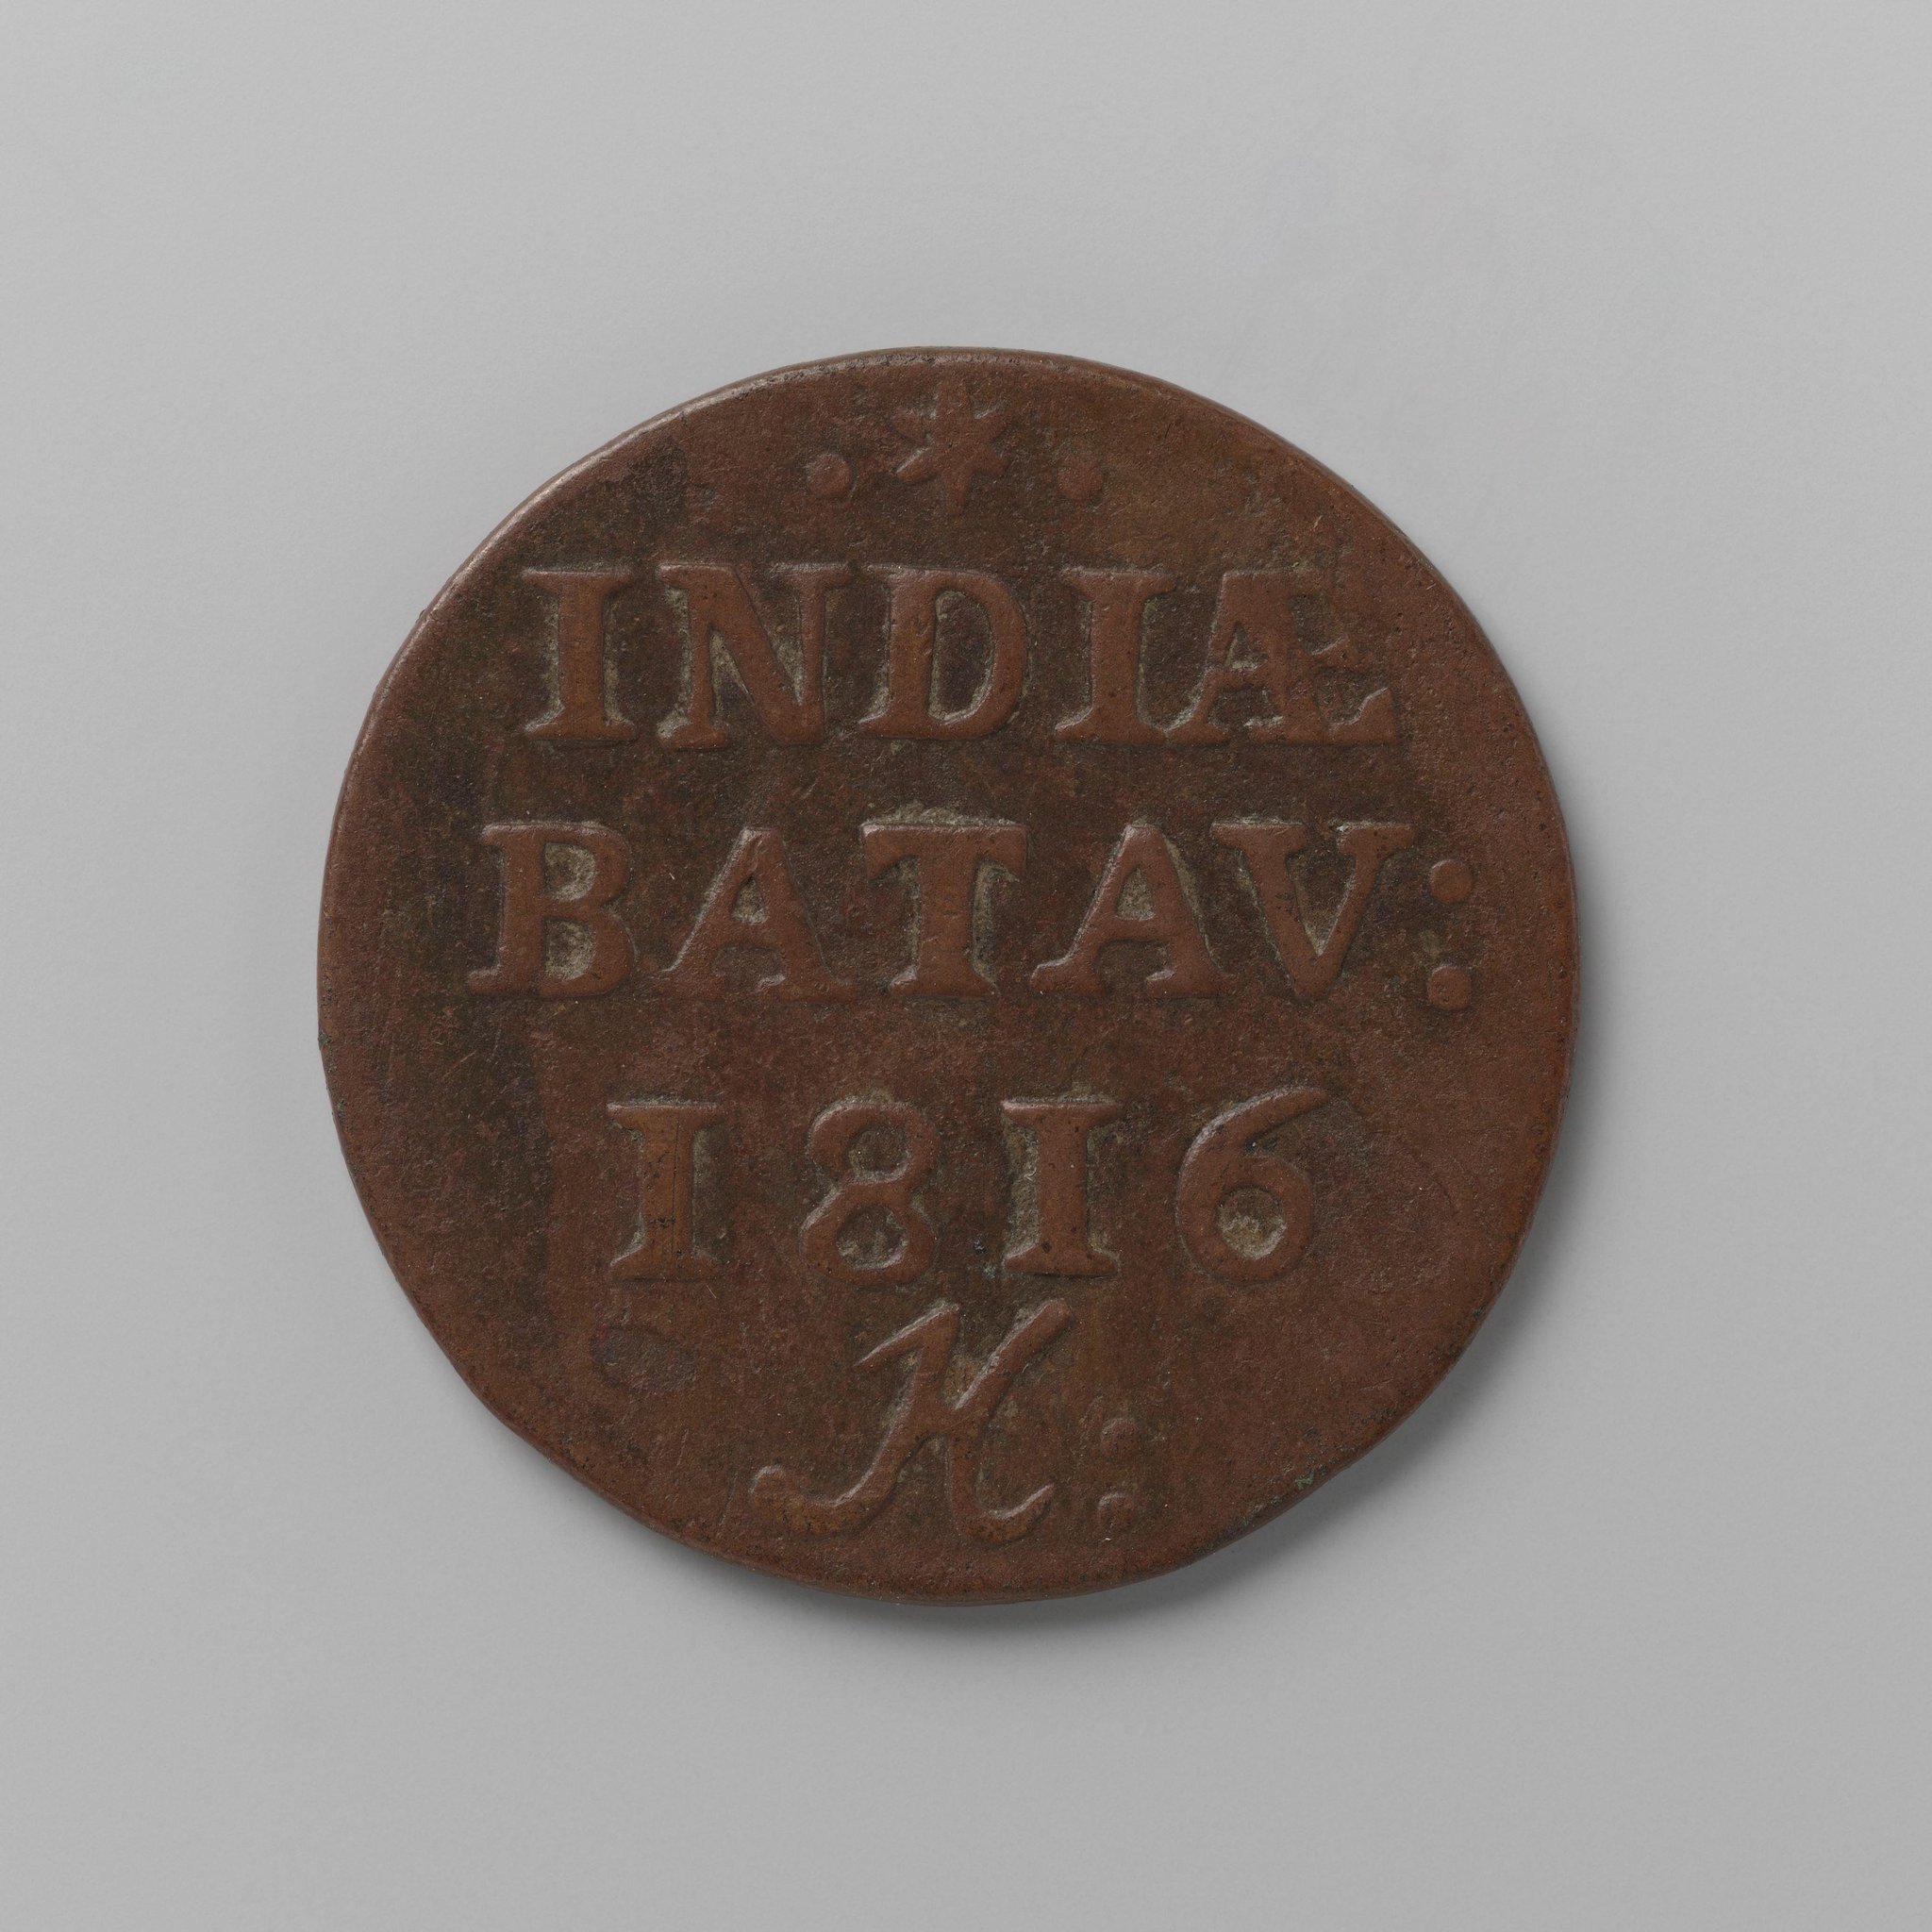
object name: coin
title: Nederlands Indië, duit de Heus Amsterdam,1816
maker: william i of the netherlands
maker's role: koning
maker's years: 1772-1843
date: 1816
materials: copper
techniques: striking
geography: amsterdam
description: Koperen munt. Voorzijde: tweeregelig opschrift, waarboven muntteken en waaronder jaartal. Daaronder letter H [=muntmeester De Heus]. Keerzijde: tussen waarde-aanduiding 5 1/16 G gekroond generaliteitswapenschild. Gladde rand.